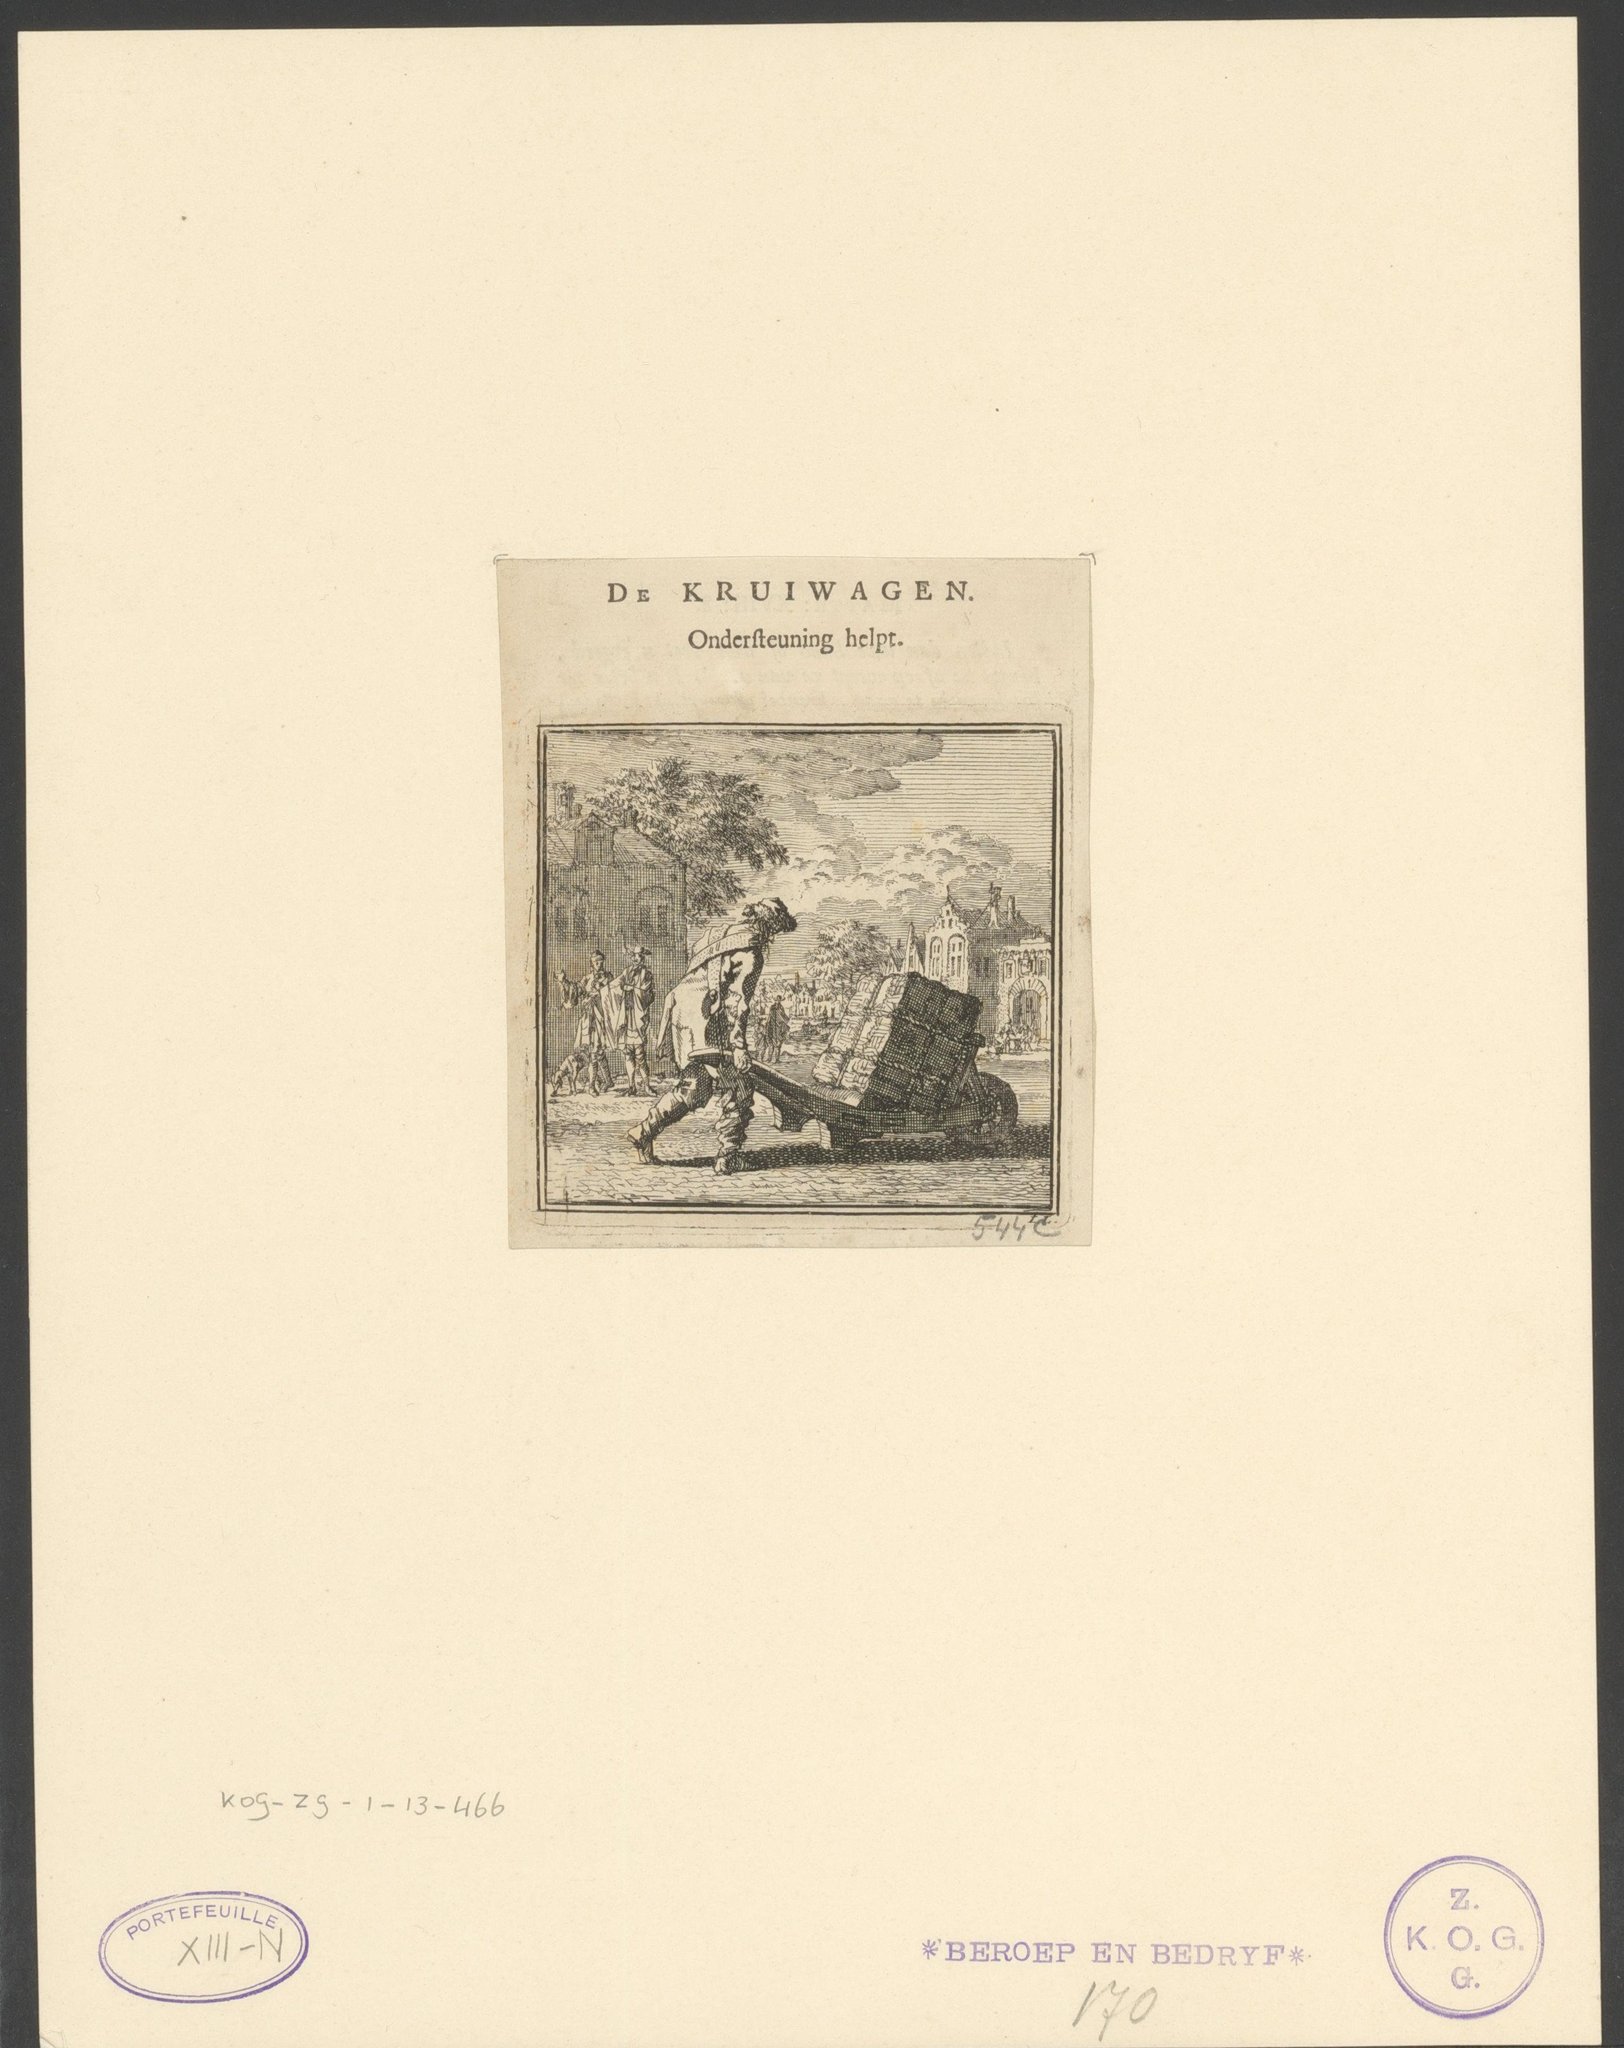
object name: book illustration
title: De Kruiwagen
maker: jan luyken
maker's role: draughtsman, print maker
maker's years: 1649-1712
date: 1711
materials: paper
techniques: etching, letterpress printing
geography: amsterdam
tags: wheelbarrow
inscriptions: stamp, collector's mark: Lugt 1641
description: Onderwerpsrubrieken binnen de Atlas Zeden en Gewoonten: Handel, Nijverheid en verkeer, Beroep en bedrijf, Mannelijk, Kruiers.